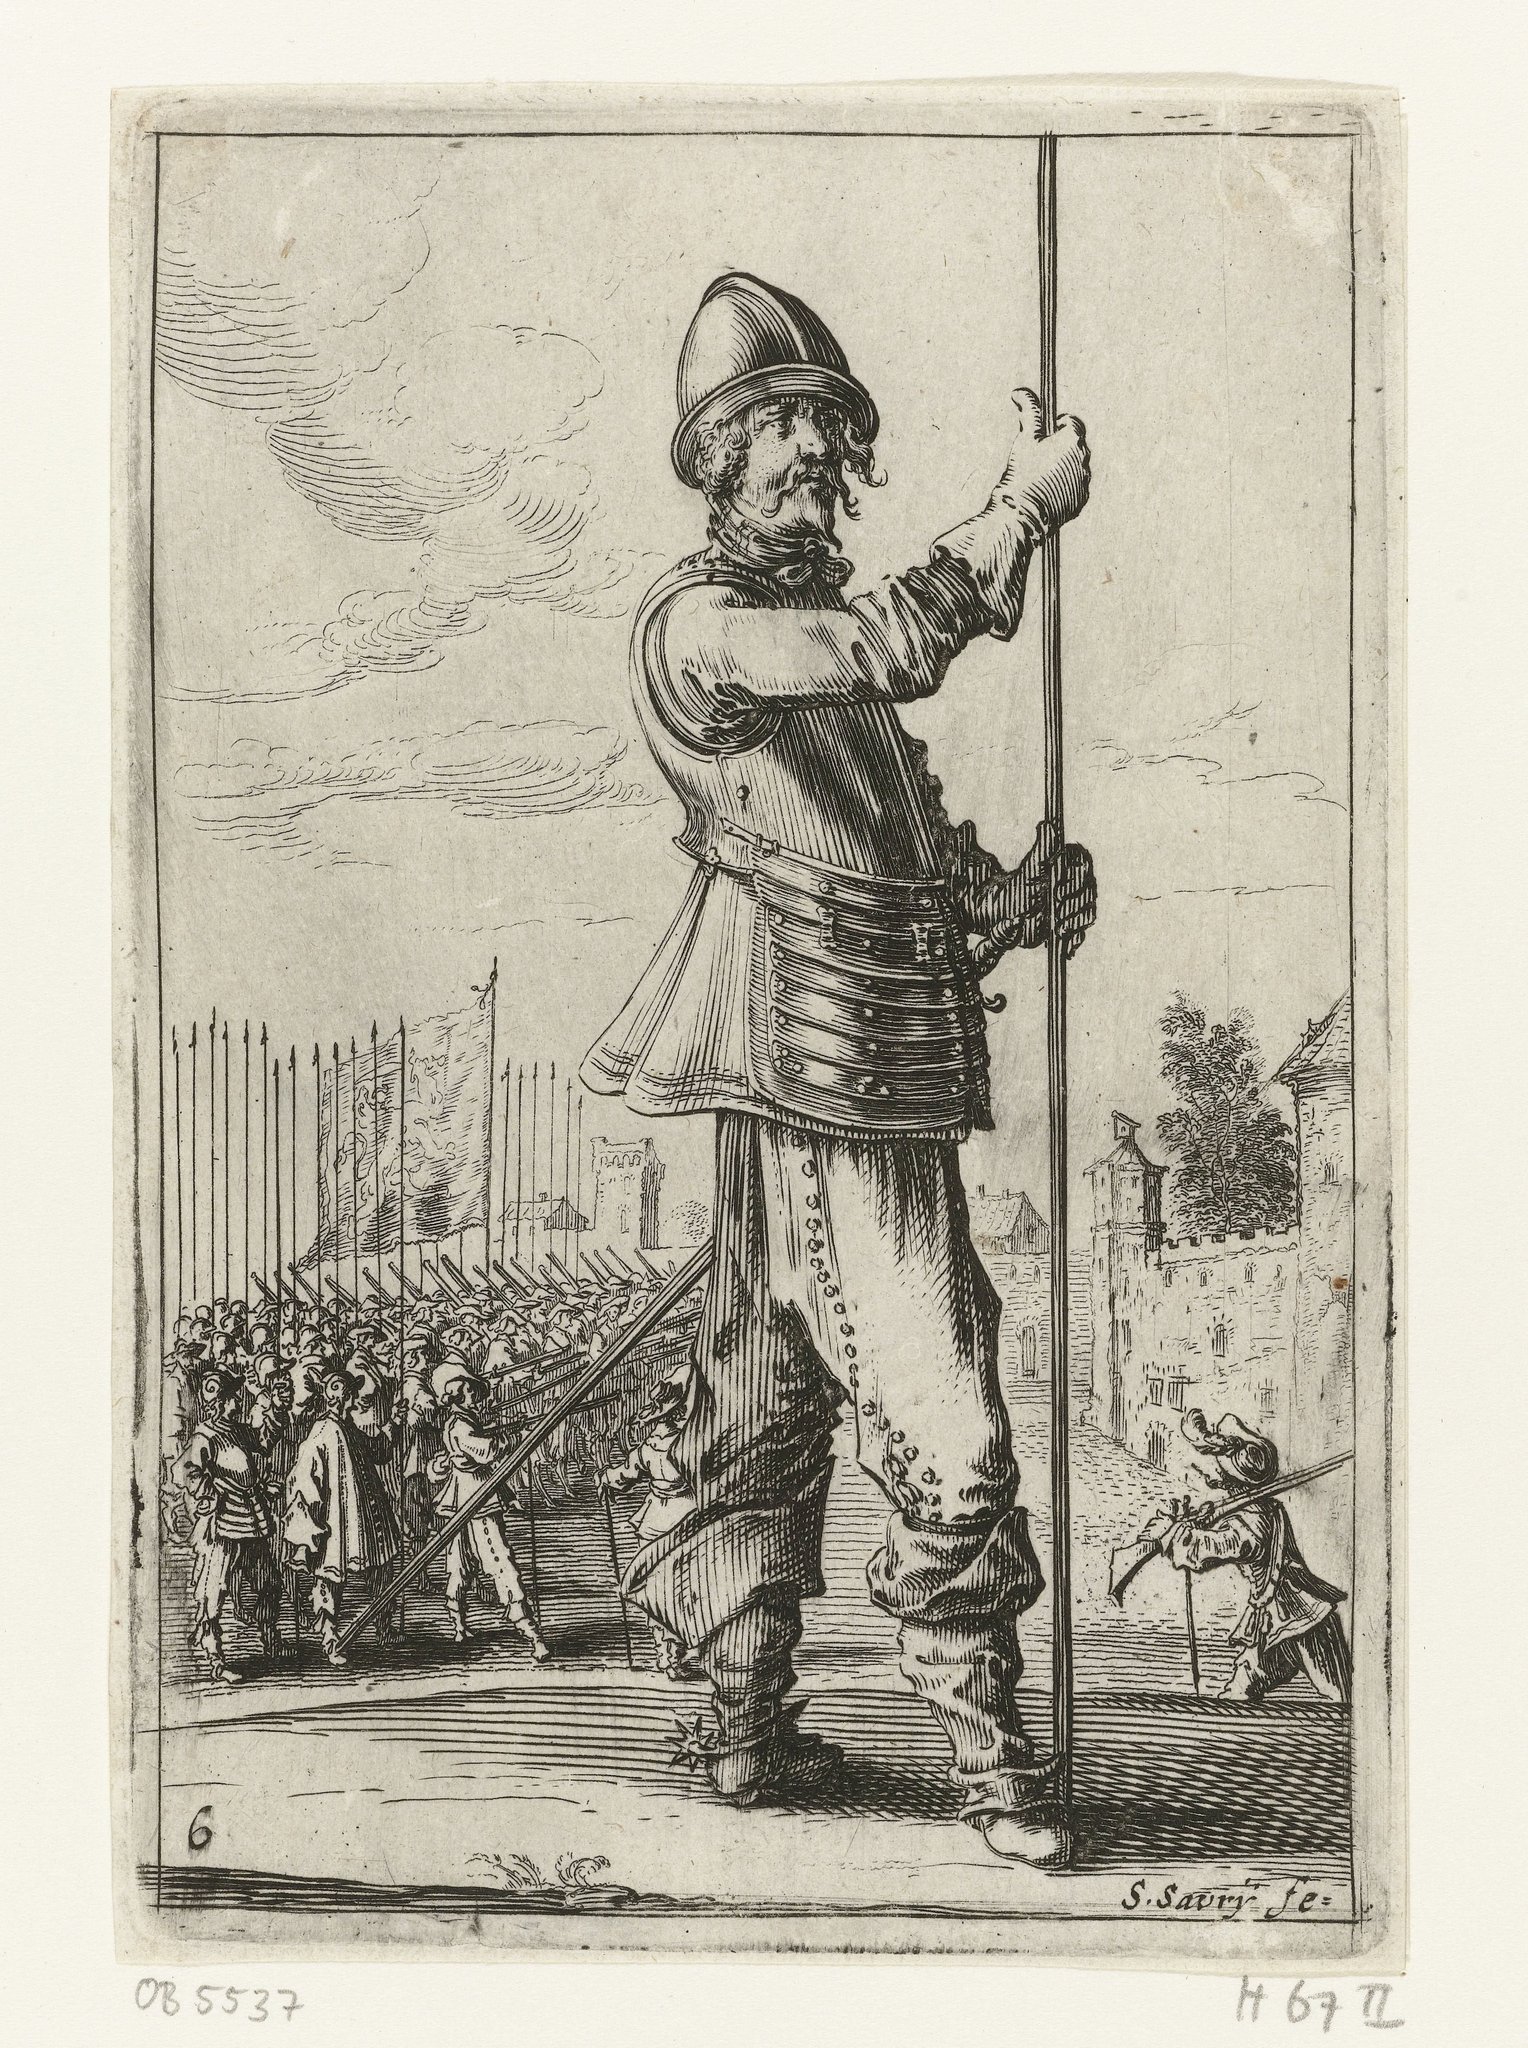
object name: costume print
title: Gewapende officieren en soldaten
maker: salomon savery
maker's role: print maker, publisher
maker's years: 1594-1683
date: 1630-1665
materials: paper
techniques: engraving, etching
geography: amsterdam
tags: helved weapons, polearms (for striking, hacking, thrusting): pike, clothes, costume (+ men's clothes), the soldier; the soldier's life, land forces (+ infantry)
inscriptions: collector's mark: Lugt 240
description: Soldaat met speer, op de achtergrond de infanterie met vaandeldrager. De prent maakt deel uit van een tiendelige serie met voorstellingen van gewapende officieren en soldaten, gekleed volgens de Nederlandse mode ca. 1625-1635.